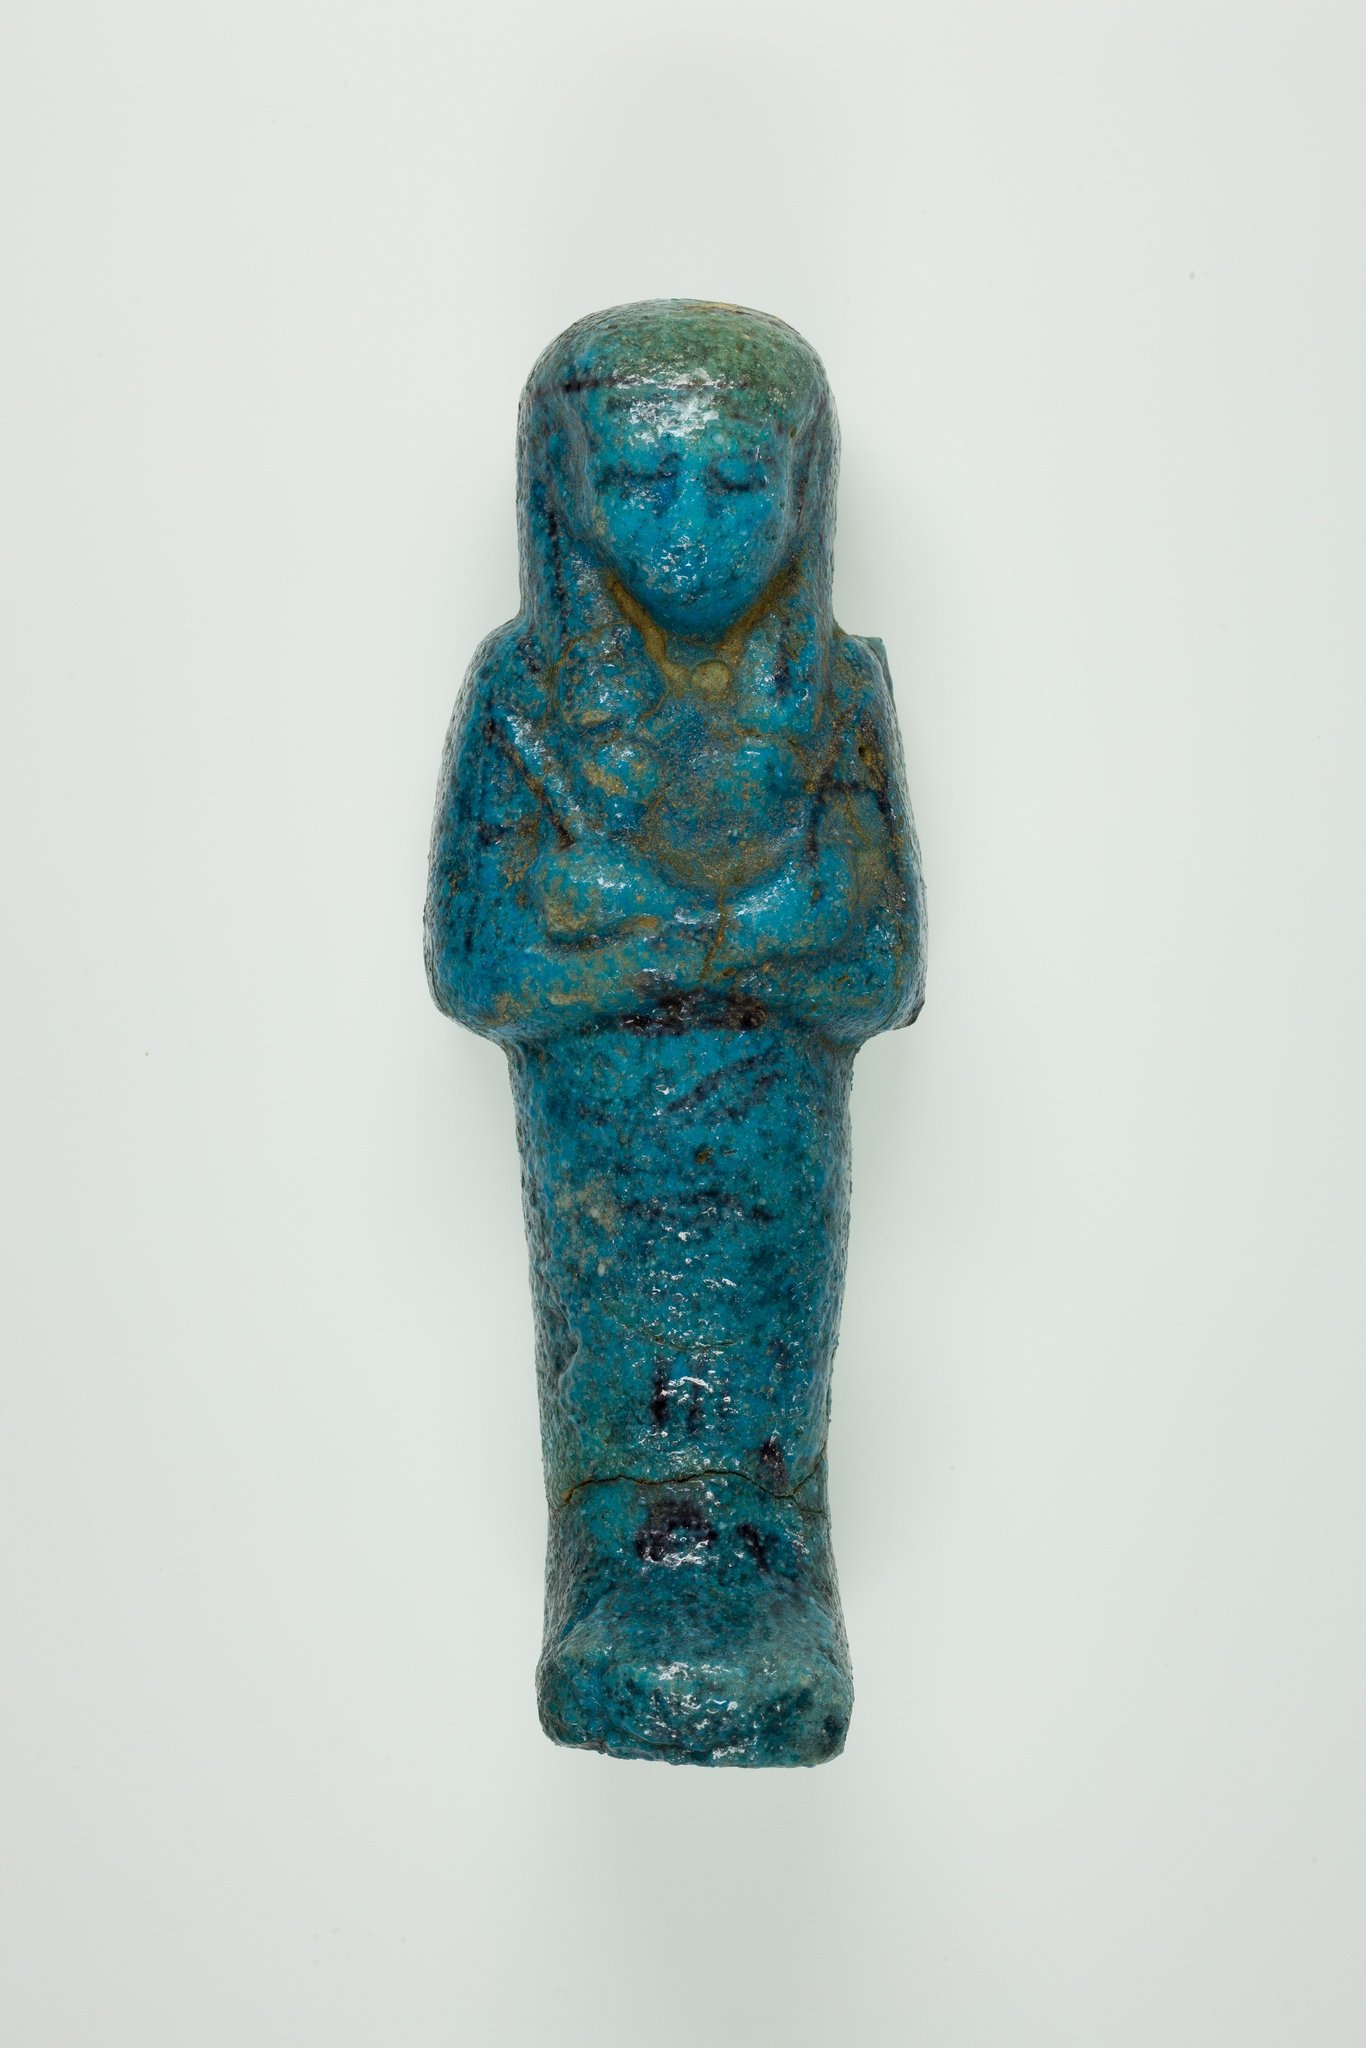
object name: worker shabti, henettawy c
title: Worker Shabti of Henettawy (C), Daughter of Isetemkheb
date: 990-970 BCE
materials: faience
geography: egypt